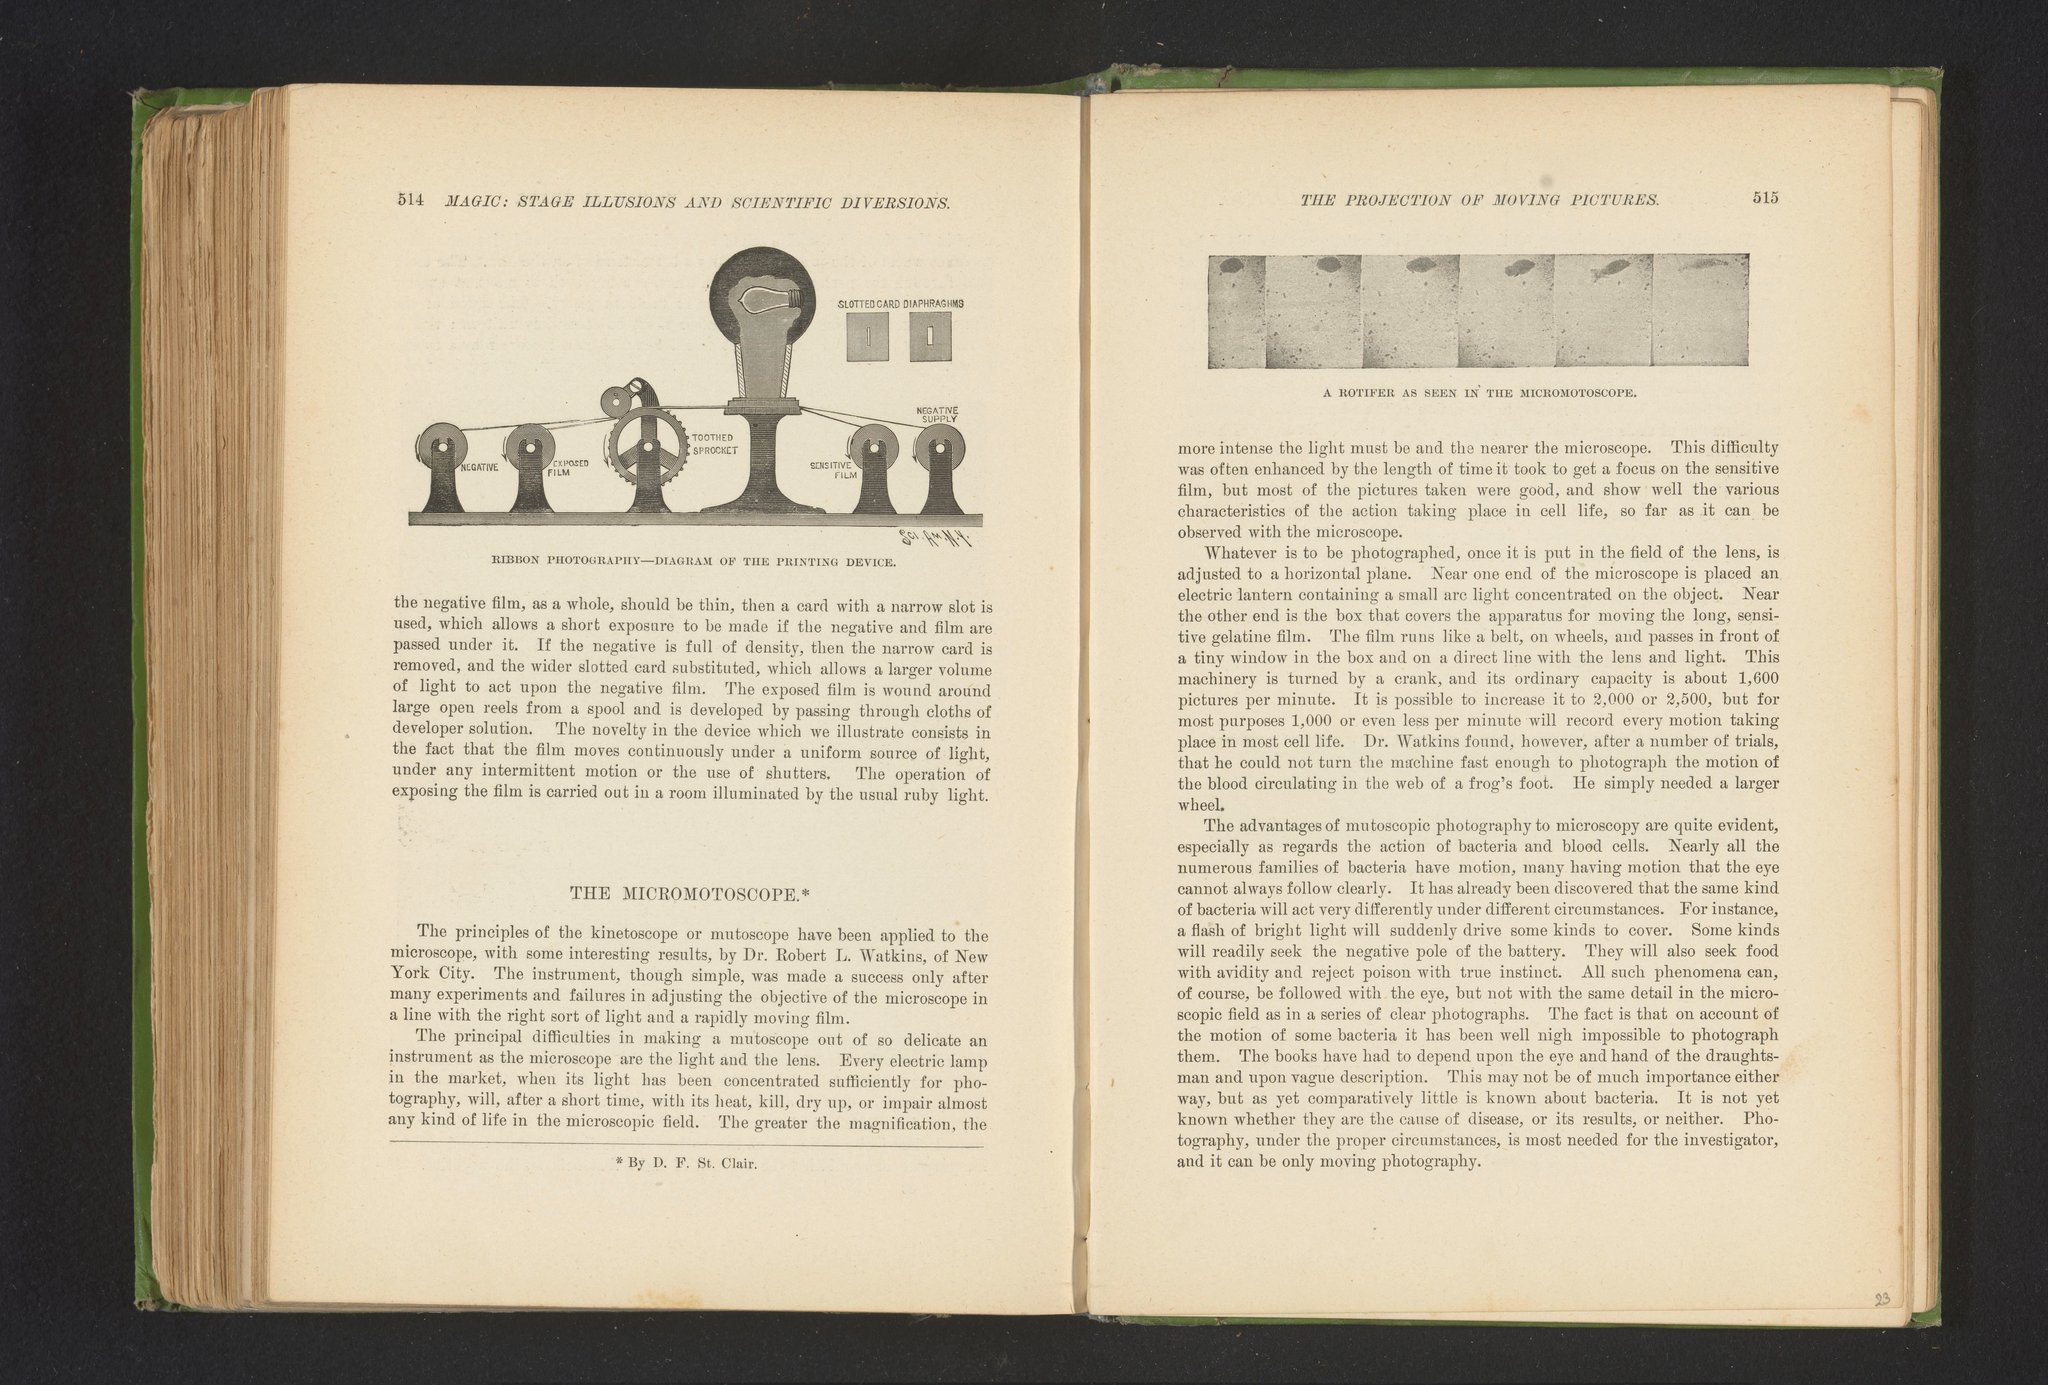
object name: page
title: A Rotifer as Seen in the Micromotoscope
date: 1892-1897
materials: paper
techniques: autotype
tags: lower animals